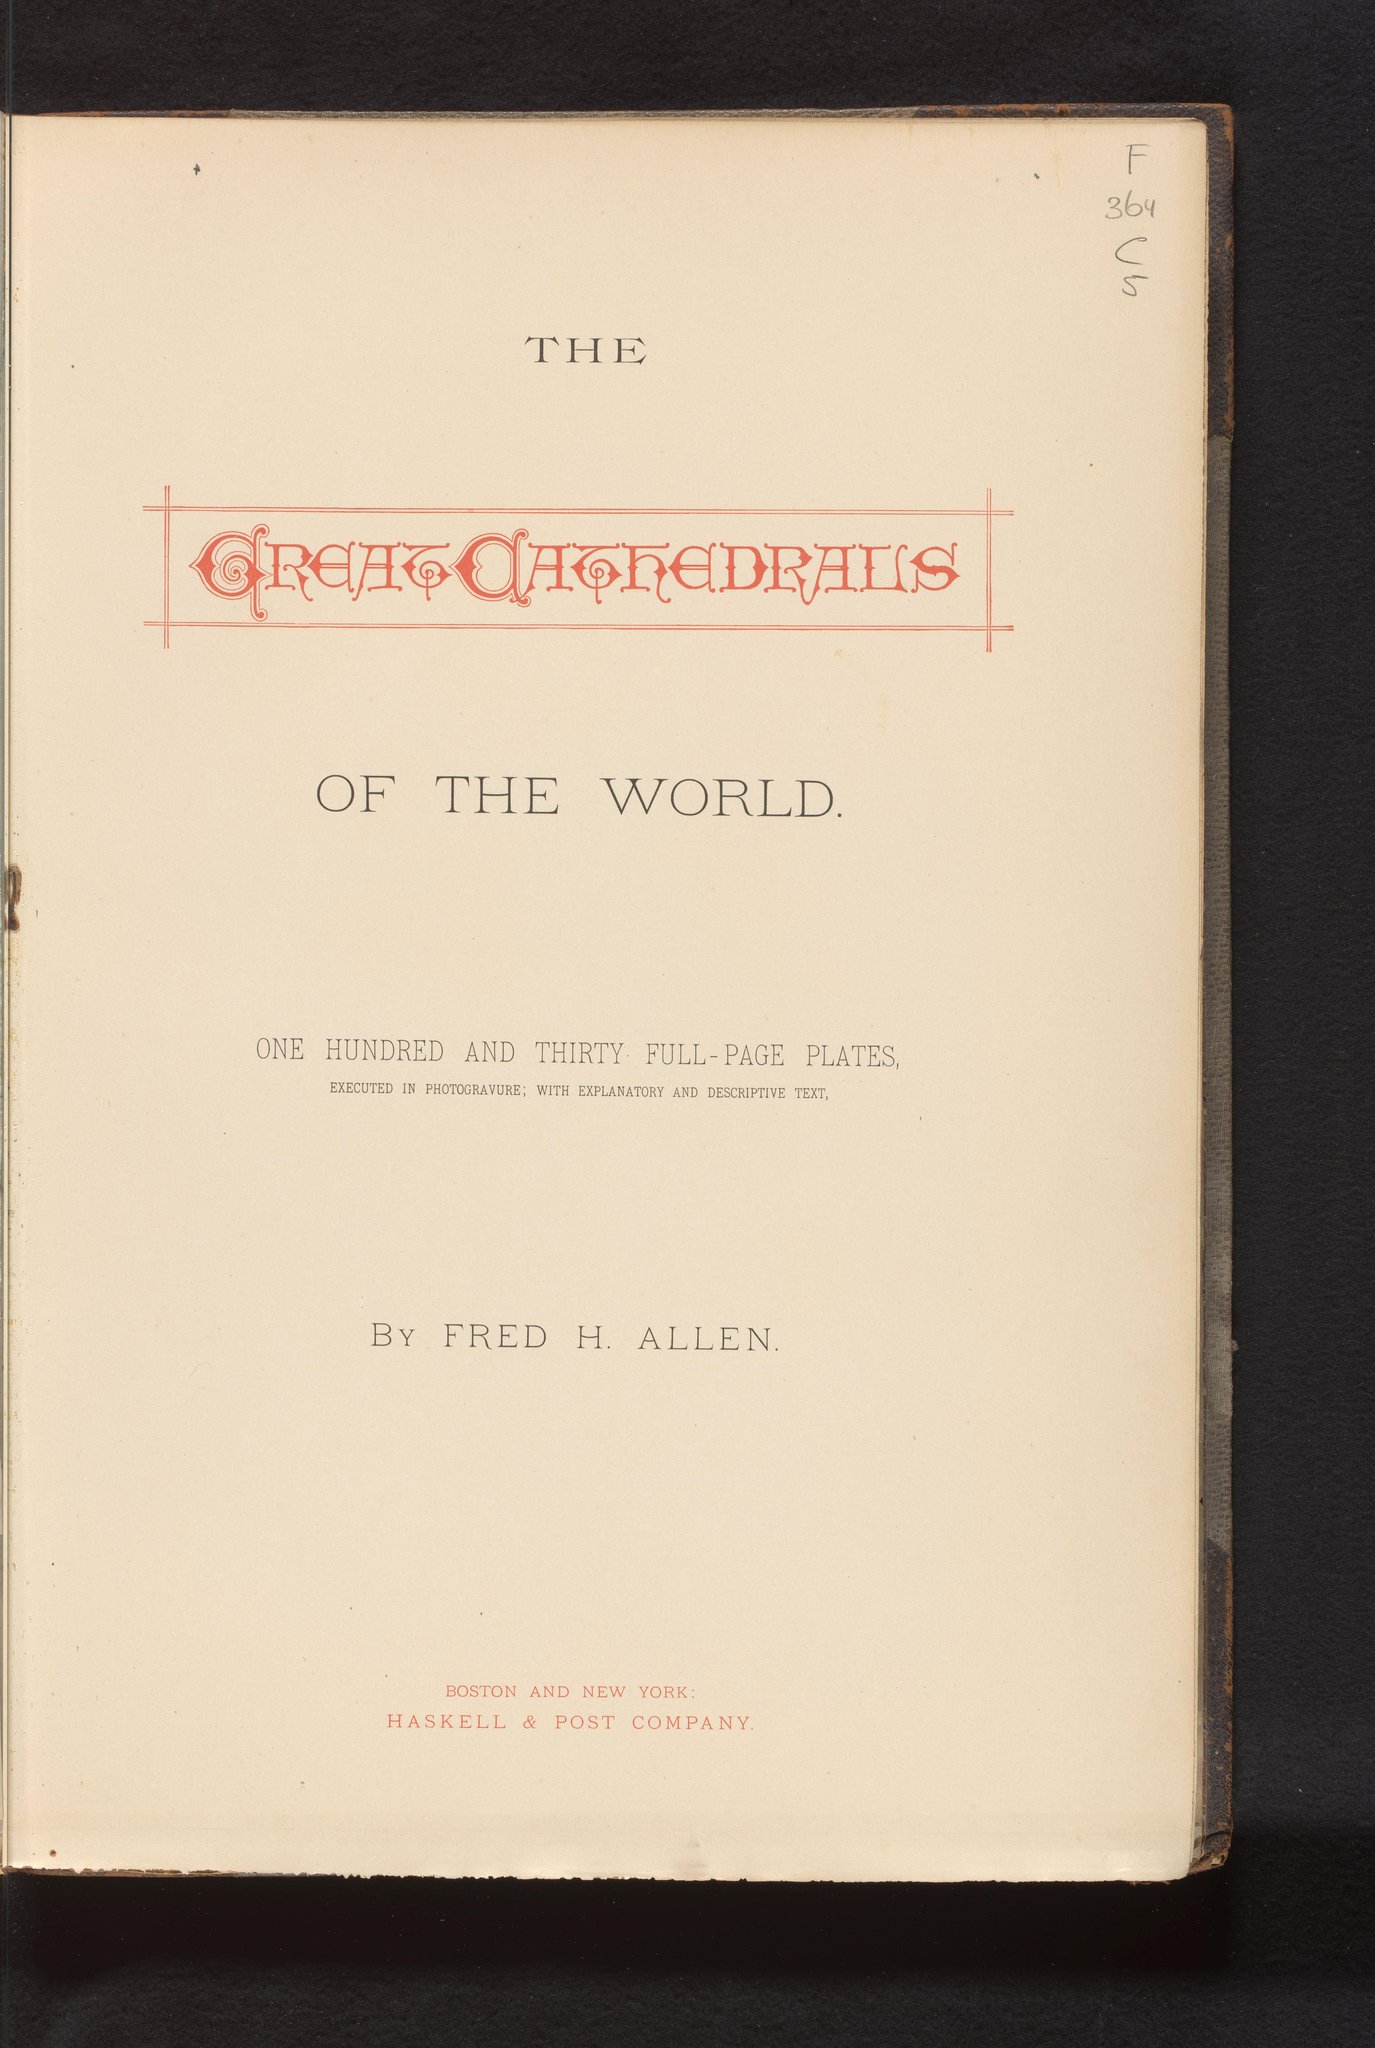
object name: book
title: The great cathedrals of the world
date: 1886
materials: linen, paper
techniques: photograph, printing, marbled paper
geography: boston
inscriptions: date: ‘AUG 1992’, annotation: ‘(twenty)/ vol. 2 only/ [...]’, bookplate: ‘Richard Lavrence Pemberton, The Barnes & Hawthorn Tower’